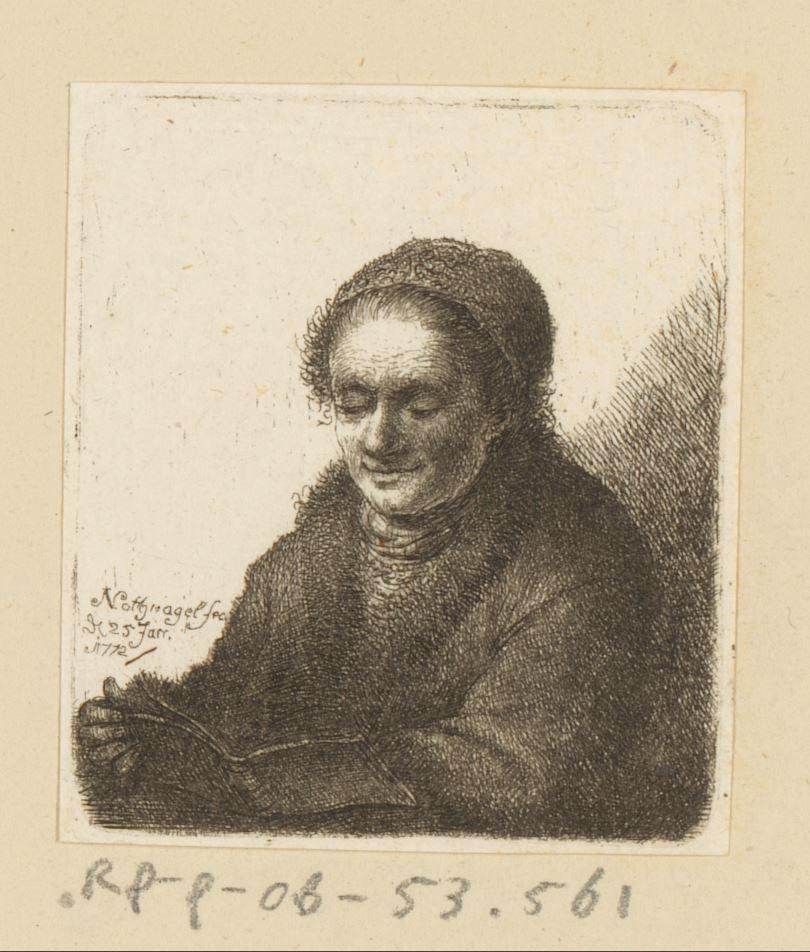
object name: print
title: Lezende vrouw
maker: johann andreas benjamin nothnagel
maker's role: print maker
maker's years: 1729-1804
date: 1772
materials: paper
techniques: etching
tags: adult woman, reading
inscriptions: collector's mark: Lugt 240